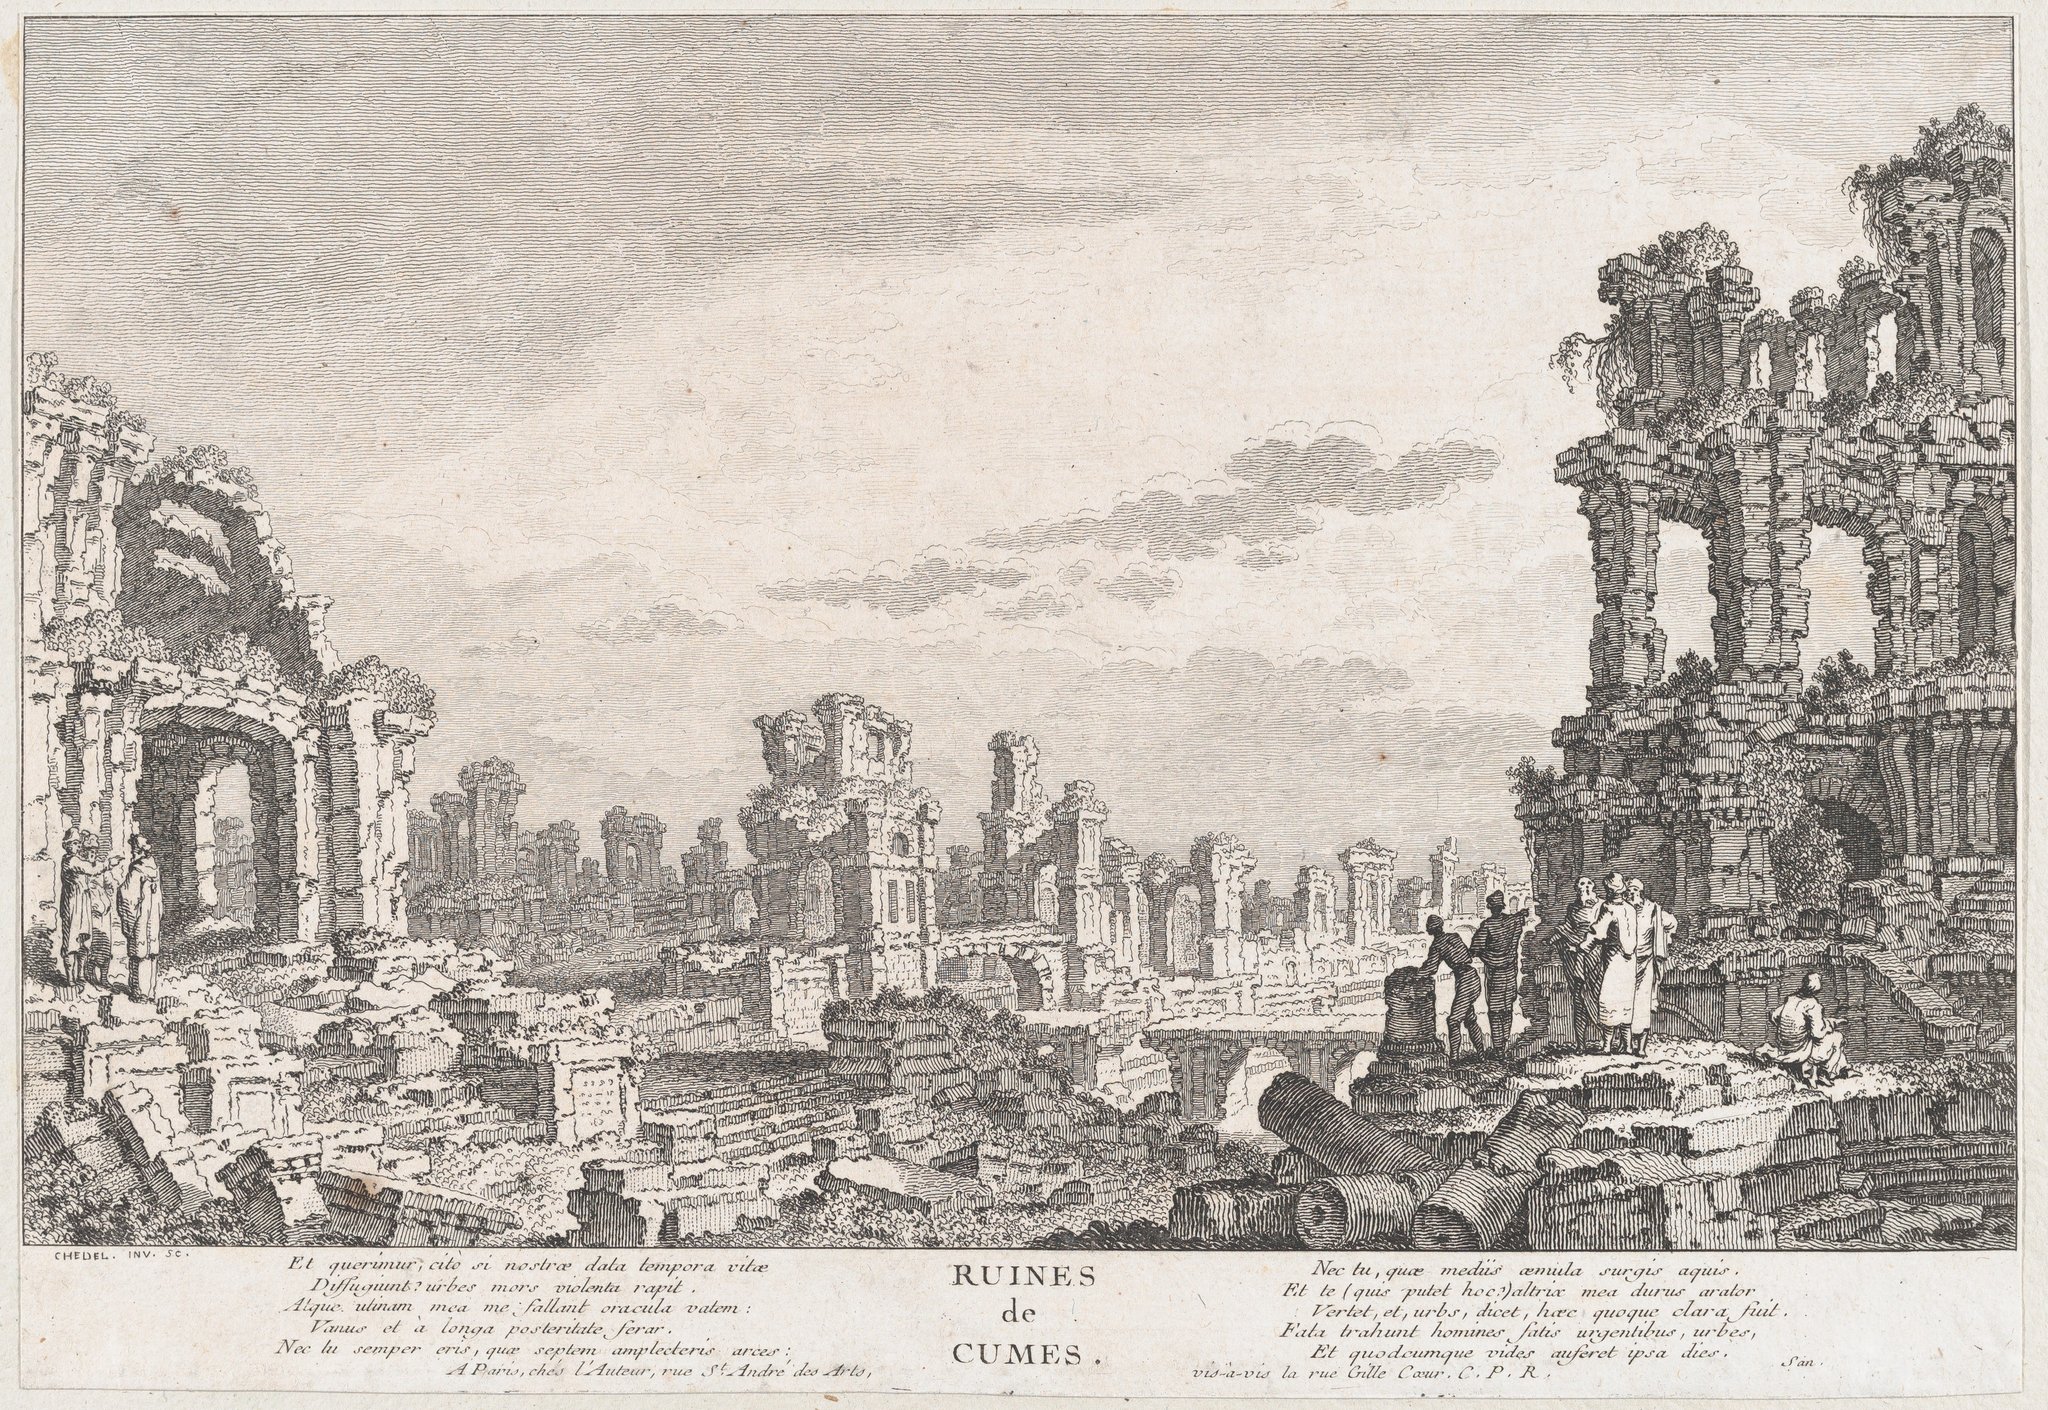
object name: print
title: Ruines de Cumes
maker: quentin pierre chedel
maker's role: artist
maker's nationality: french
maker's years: 1705-1763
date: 1701-1800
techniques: etching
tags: human figures,ruins